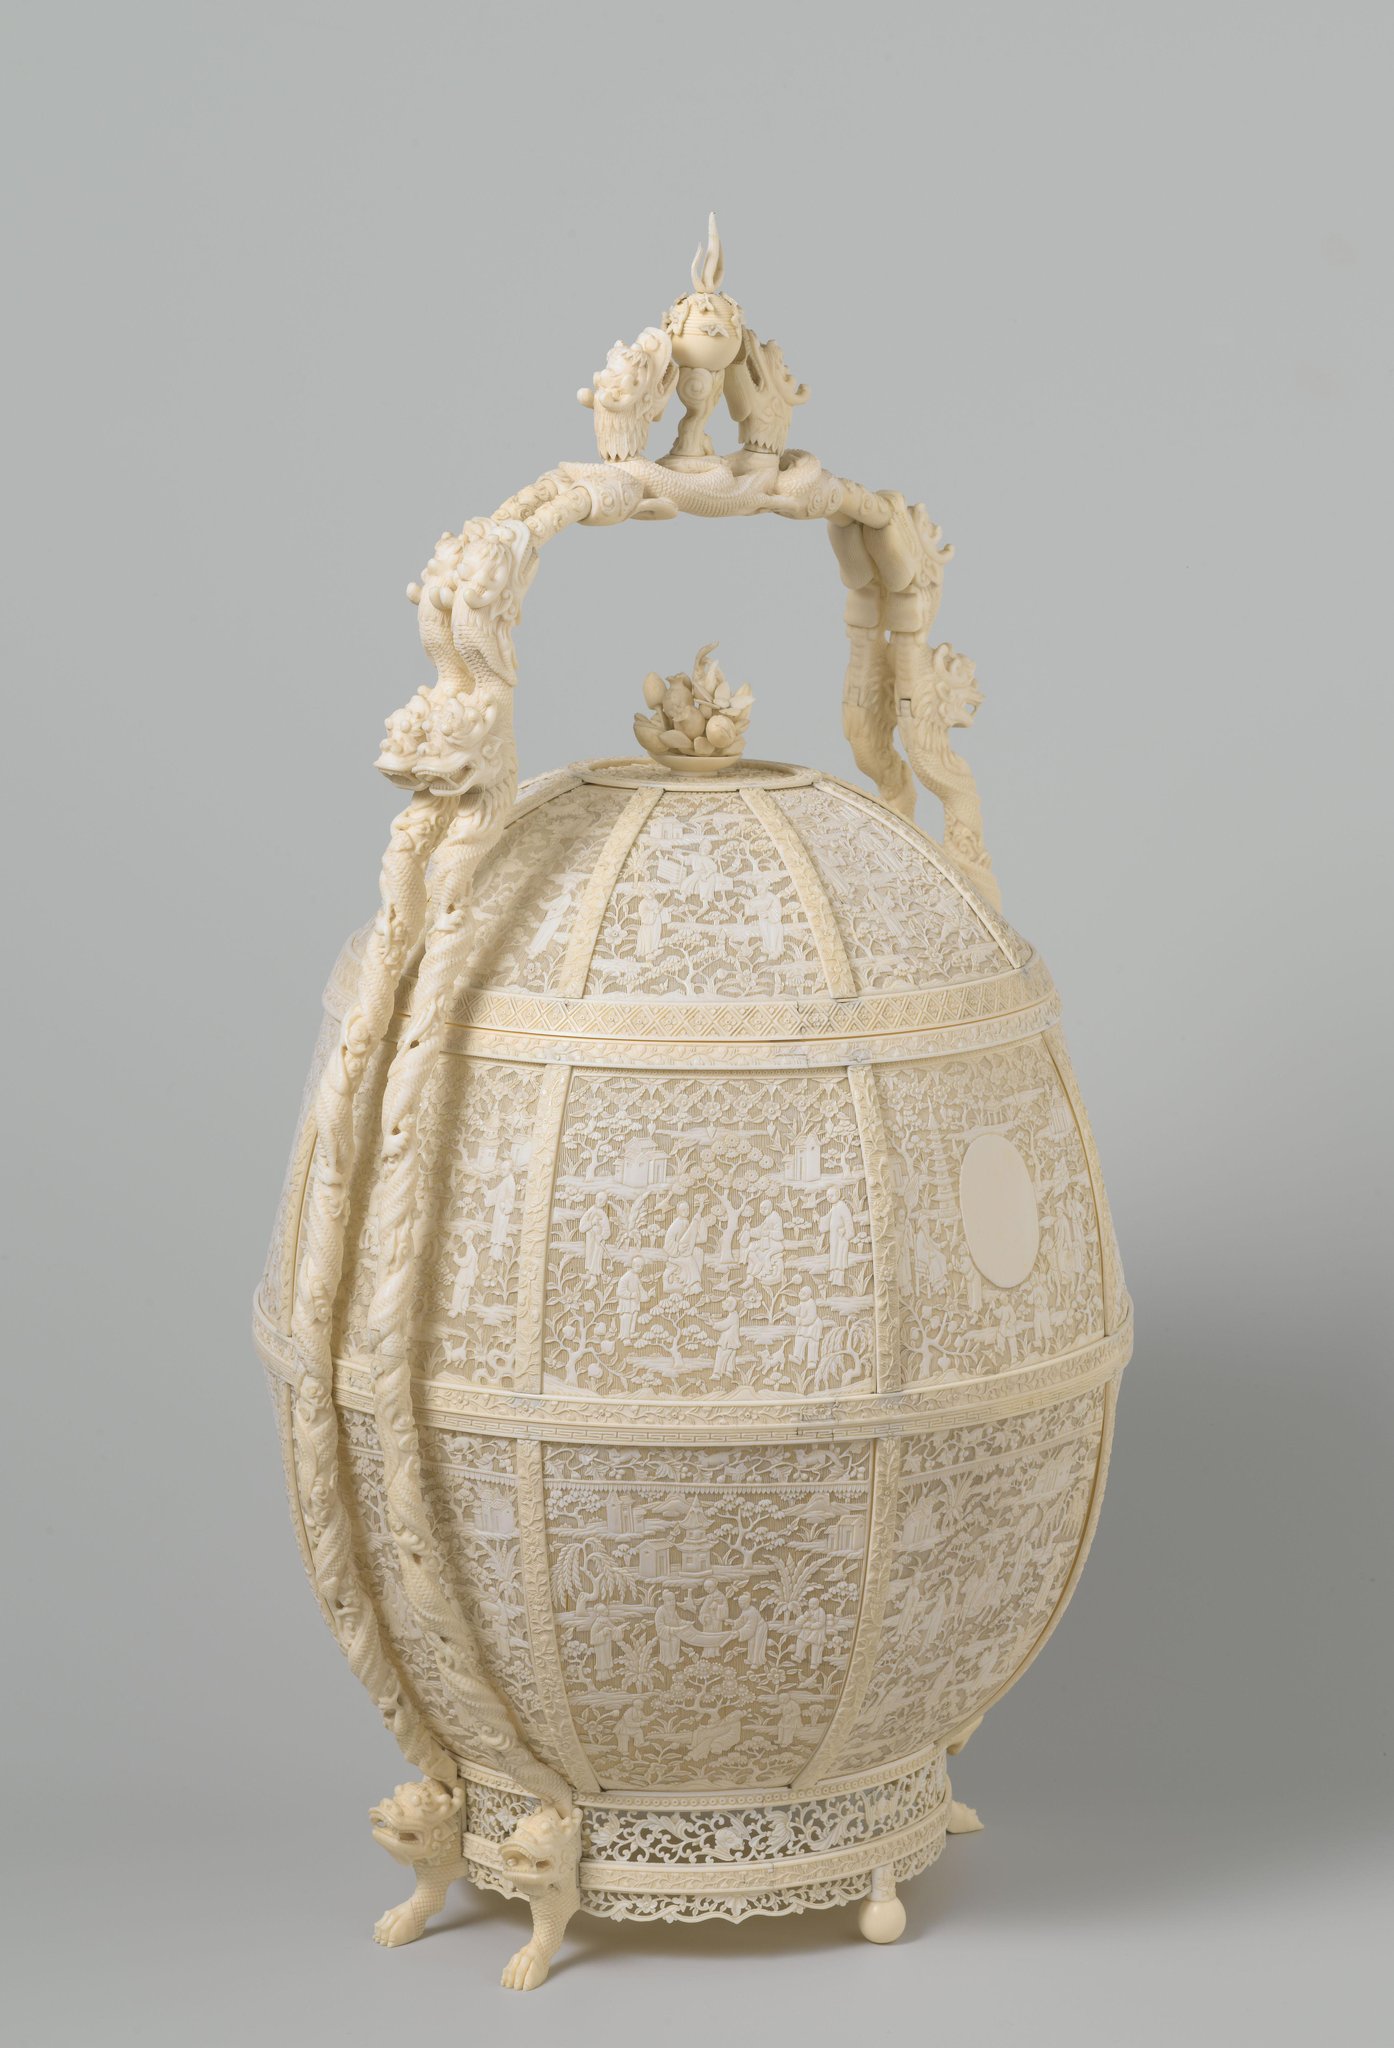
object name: stapeldoos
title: Onderdeel van een grote ivoren stapeldoos met opengewerkte panelen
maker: Anonymous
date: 1800-1815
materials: ivory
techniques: cutting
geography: guangdong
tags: dragon, ornament derived from plant forms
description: Onderdeel van een grote ivoren stapeldoos met opengewerkte panelen.